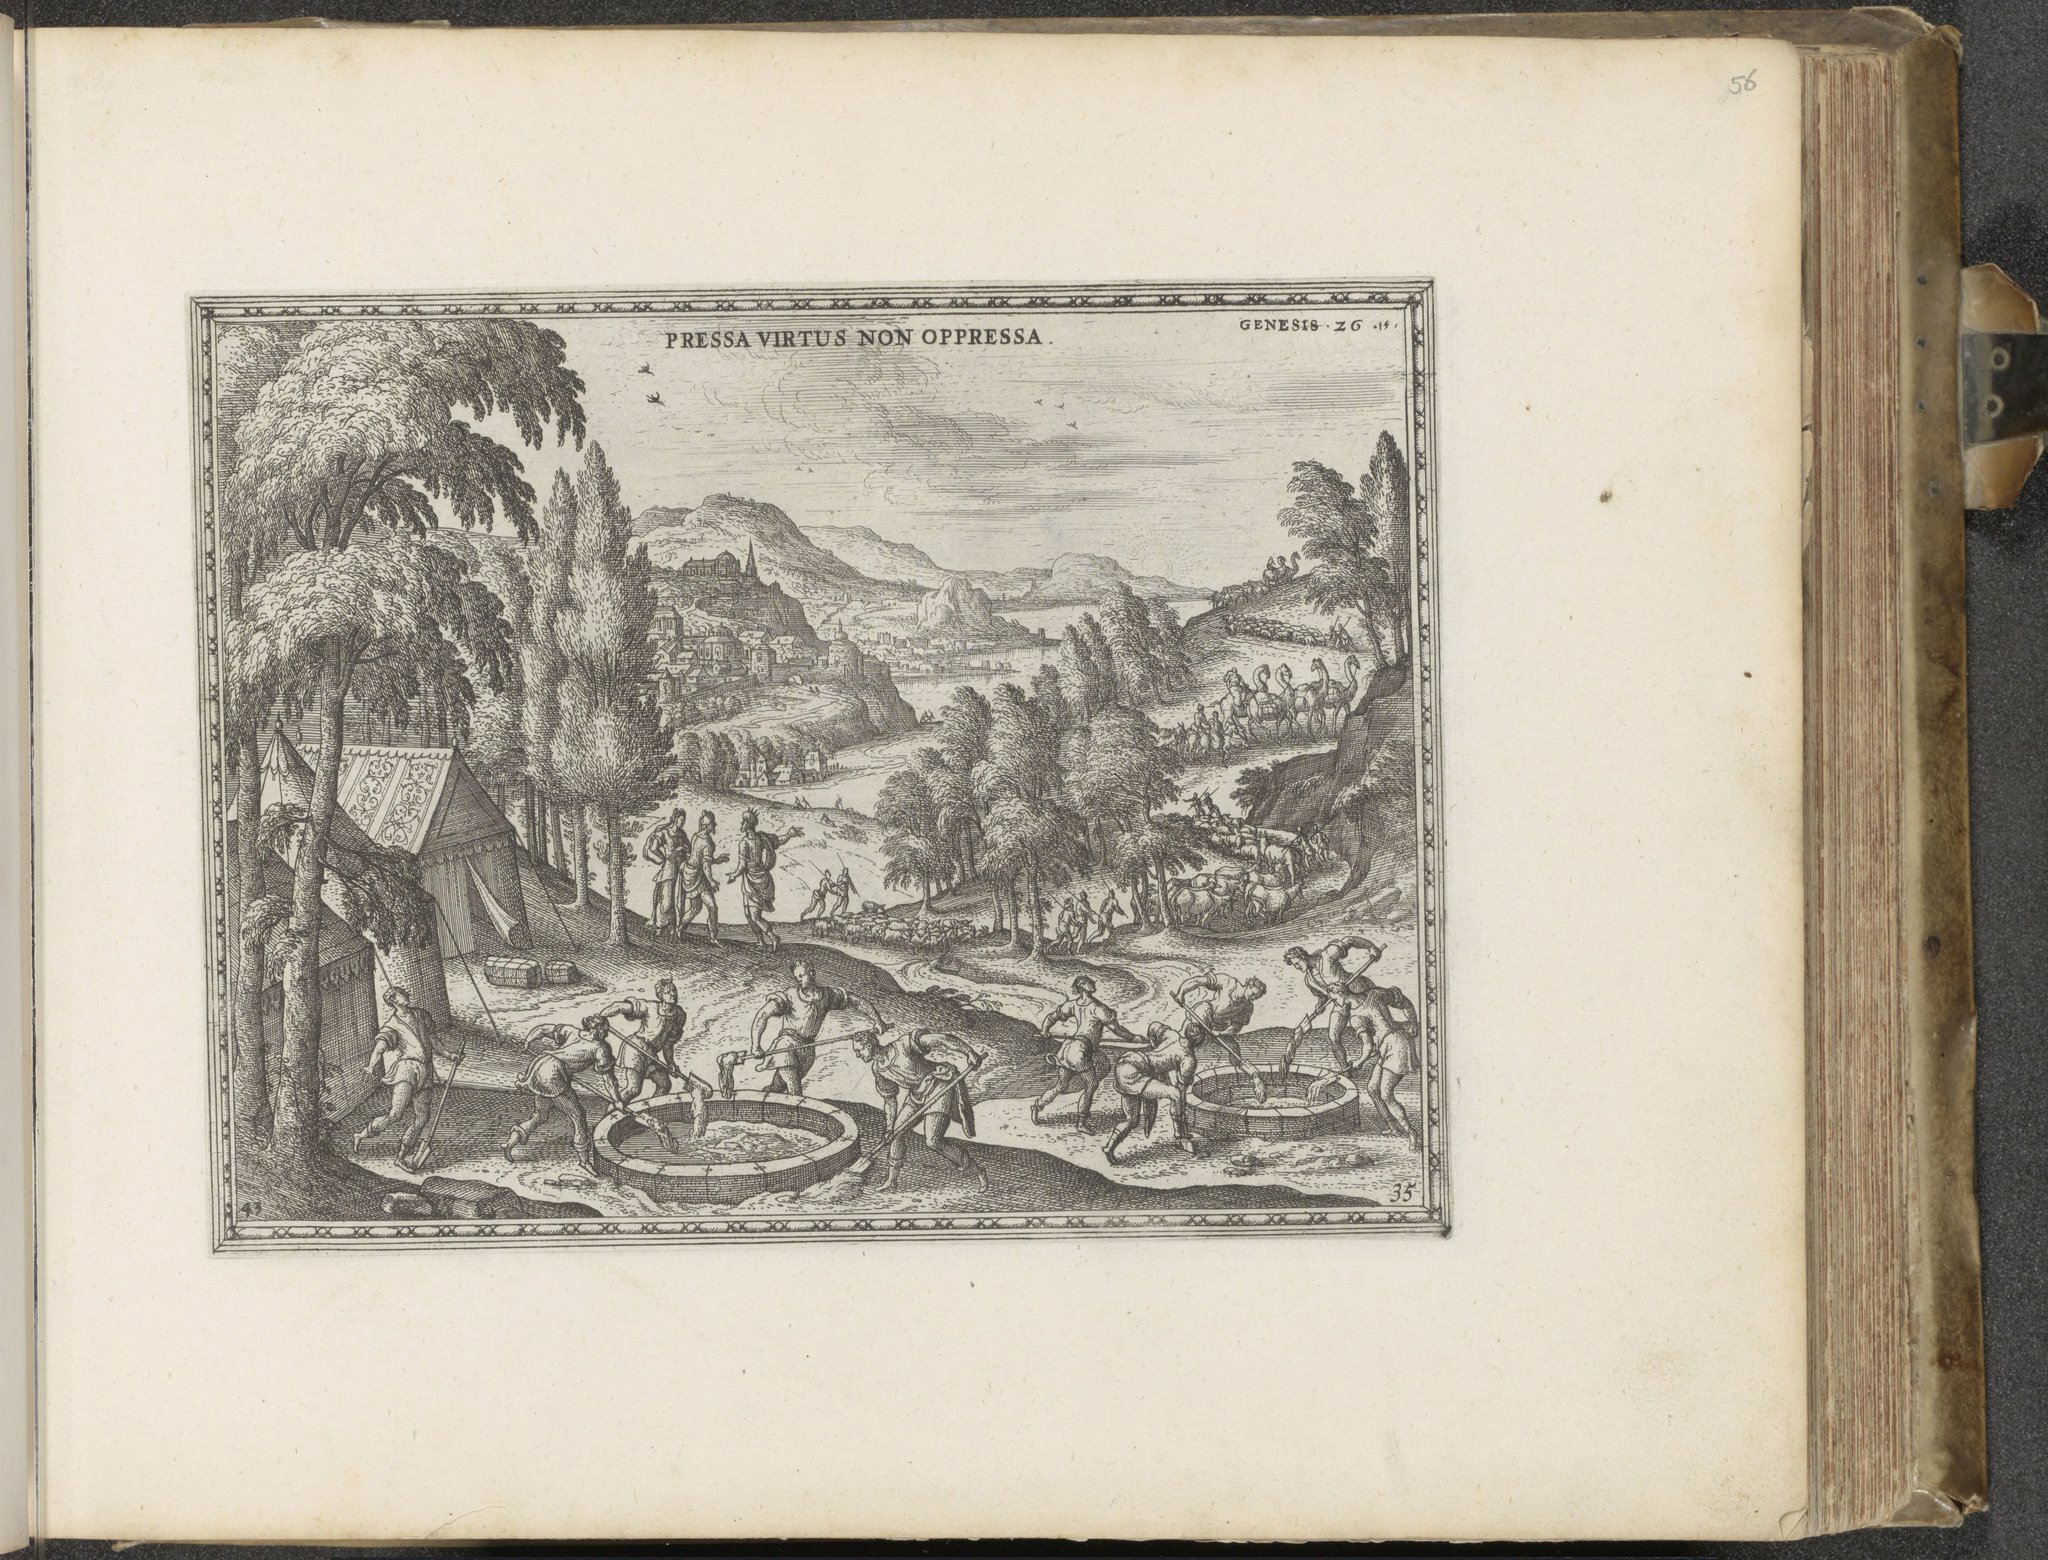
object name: album leaf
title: Imagines et figurae bibliorum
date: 1582-1593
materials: paper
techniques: etching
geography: amsterdam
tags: the envious philistines fill all abraham's wells with earth, abimelech asks isaac to leave the country, isaac moves to the valley of gerar, old testament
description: Op de voorgrond dempen de Filistijnen de putten die de knechten van Abraham eens hadden gegraven. Ze werden volgegooid met aarde. De Filistijnen waren jaloers op de rijkdom van Abrahams zoon Isaak. Koning Abimelech raadde Isaak en Rebekka daarop aan om te vertrekken. Rechts op de achtergrond de kudden schapen, geiten en runderen op weg naar het dal van Gerar waar Isaak met zijn vrouw ging wonen (Gen. 26:15). De prent maakt deel uit van een album.